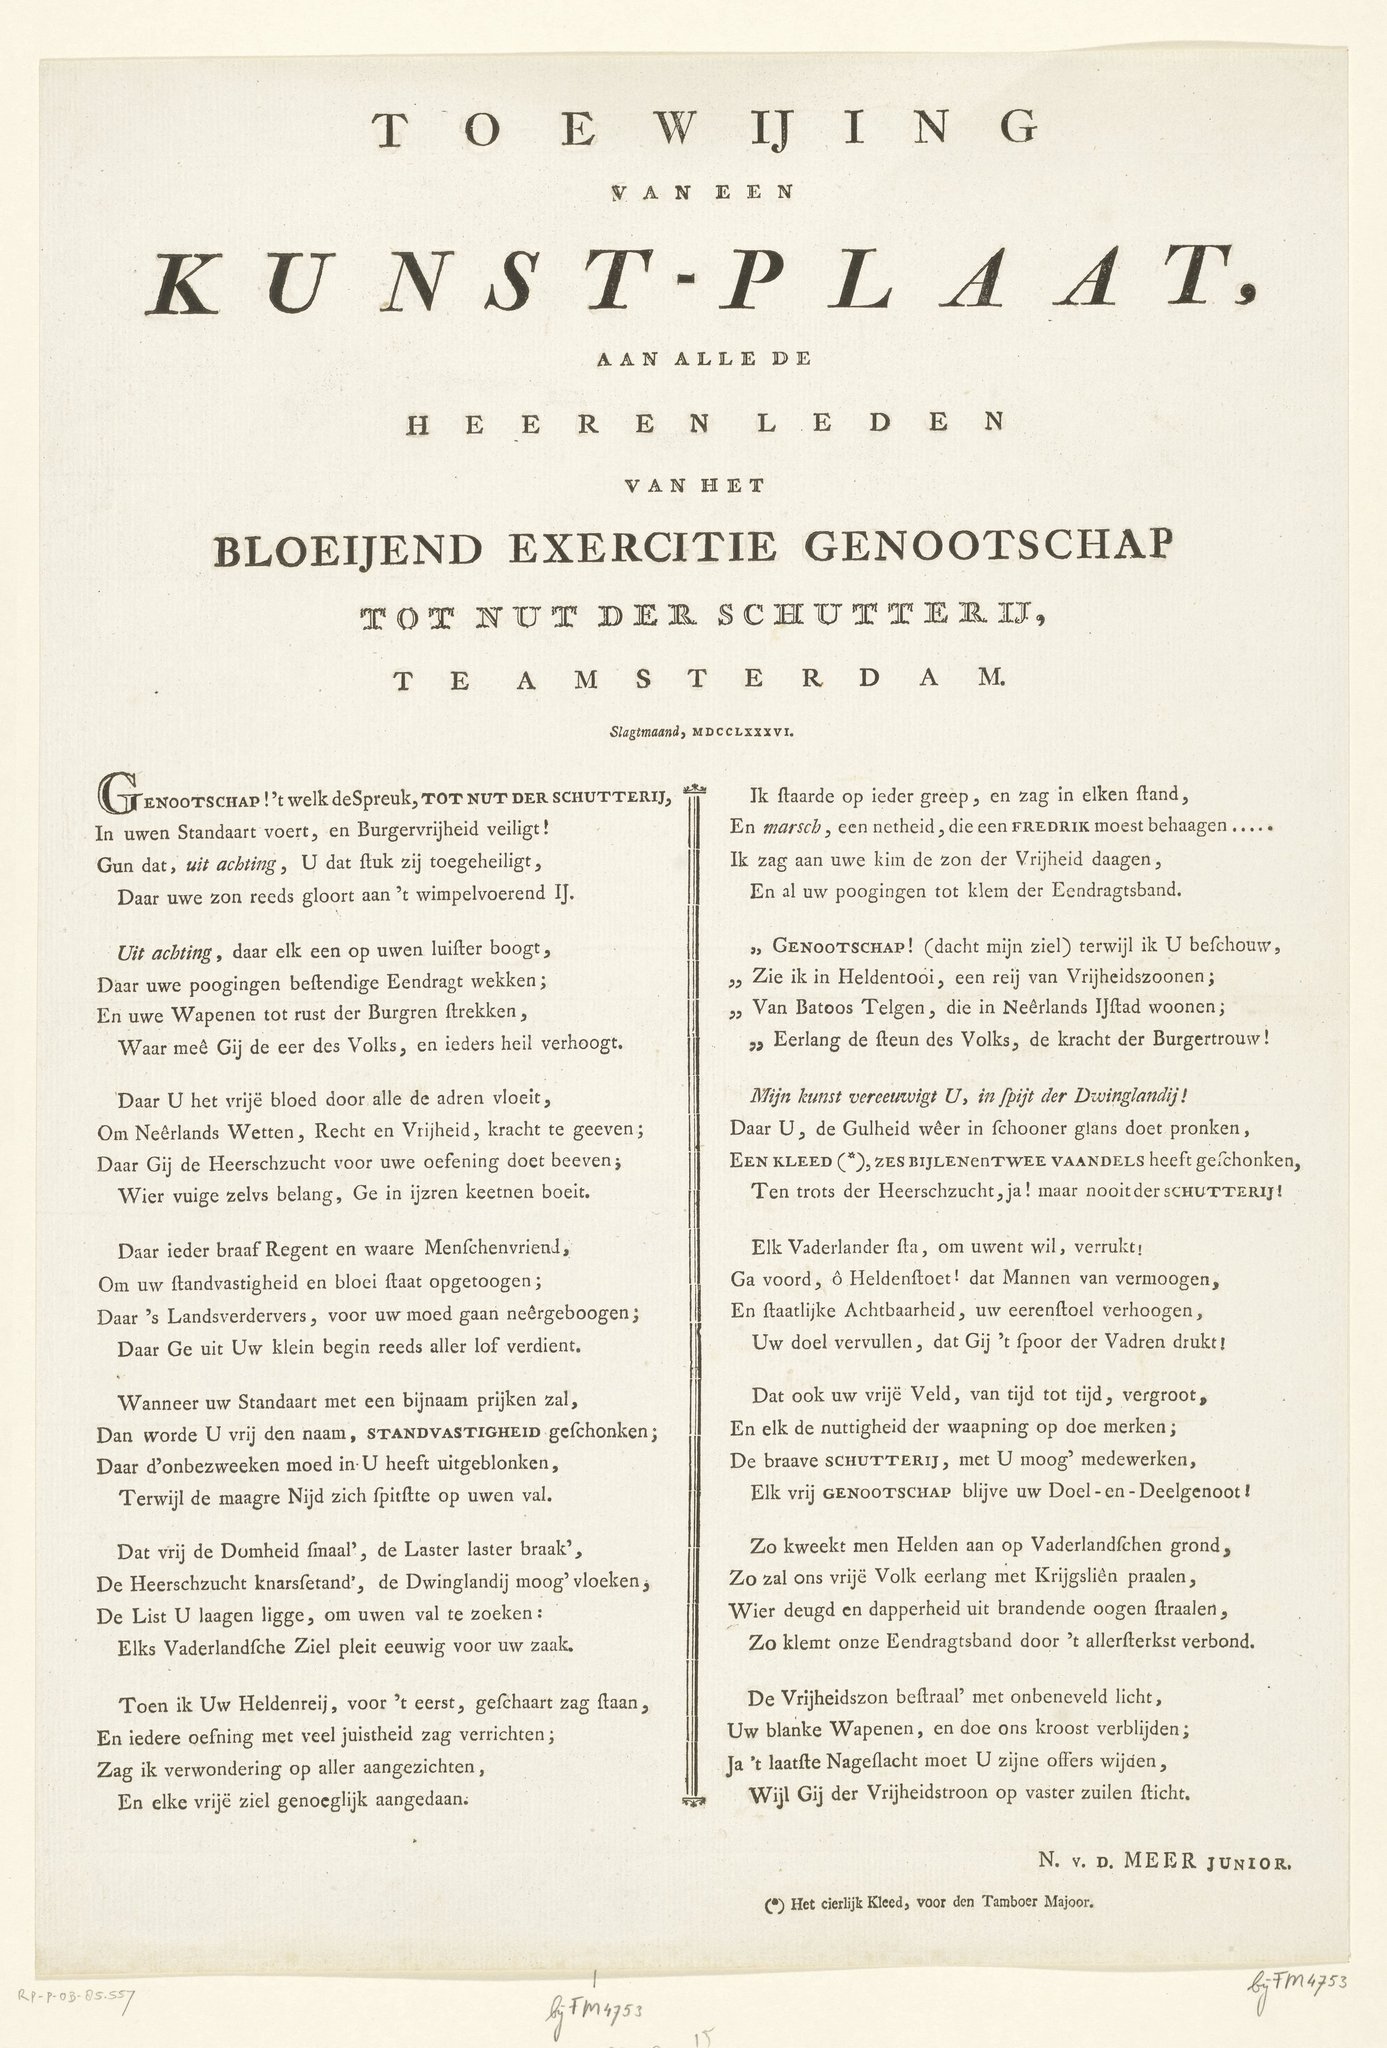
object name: text sheet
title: Toewijding van een kunst-plaat, aan alle de heeren leden van het bloeijend exercitie genootschap Tot Nut der Schutterij, te Amsterdam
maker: noach van der meer (ii)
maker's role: draughtsman, print maker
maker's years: 1741-1822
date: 1711-1786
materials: paper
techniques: letterpress printing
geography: amsterdam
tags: amsterdam, patriots (1780-1795)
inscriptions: collector's mark: Lugt 2228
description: Tekstblad met een vers van veertien coupletten waarin een plaat van de oefening van het genootschap door de dichter en graveur wordt opgedragen aan de leden van het Amsterdamse exercitiegenootschap Tot Nut der Schuttery, 1786. Tekstblad bedrukt op één zijde.